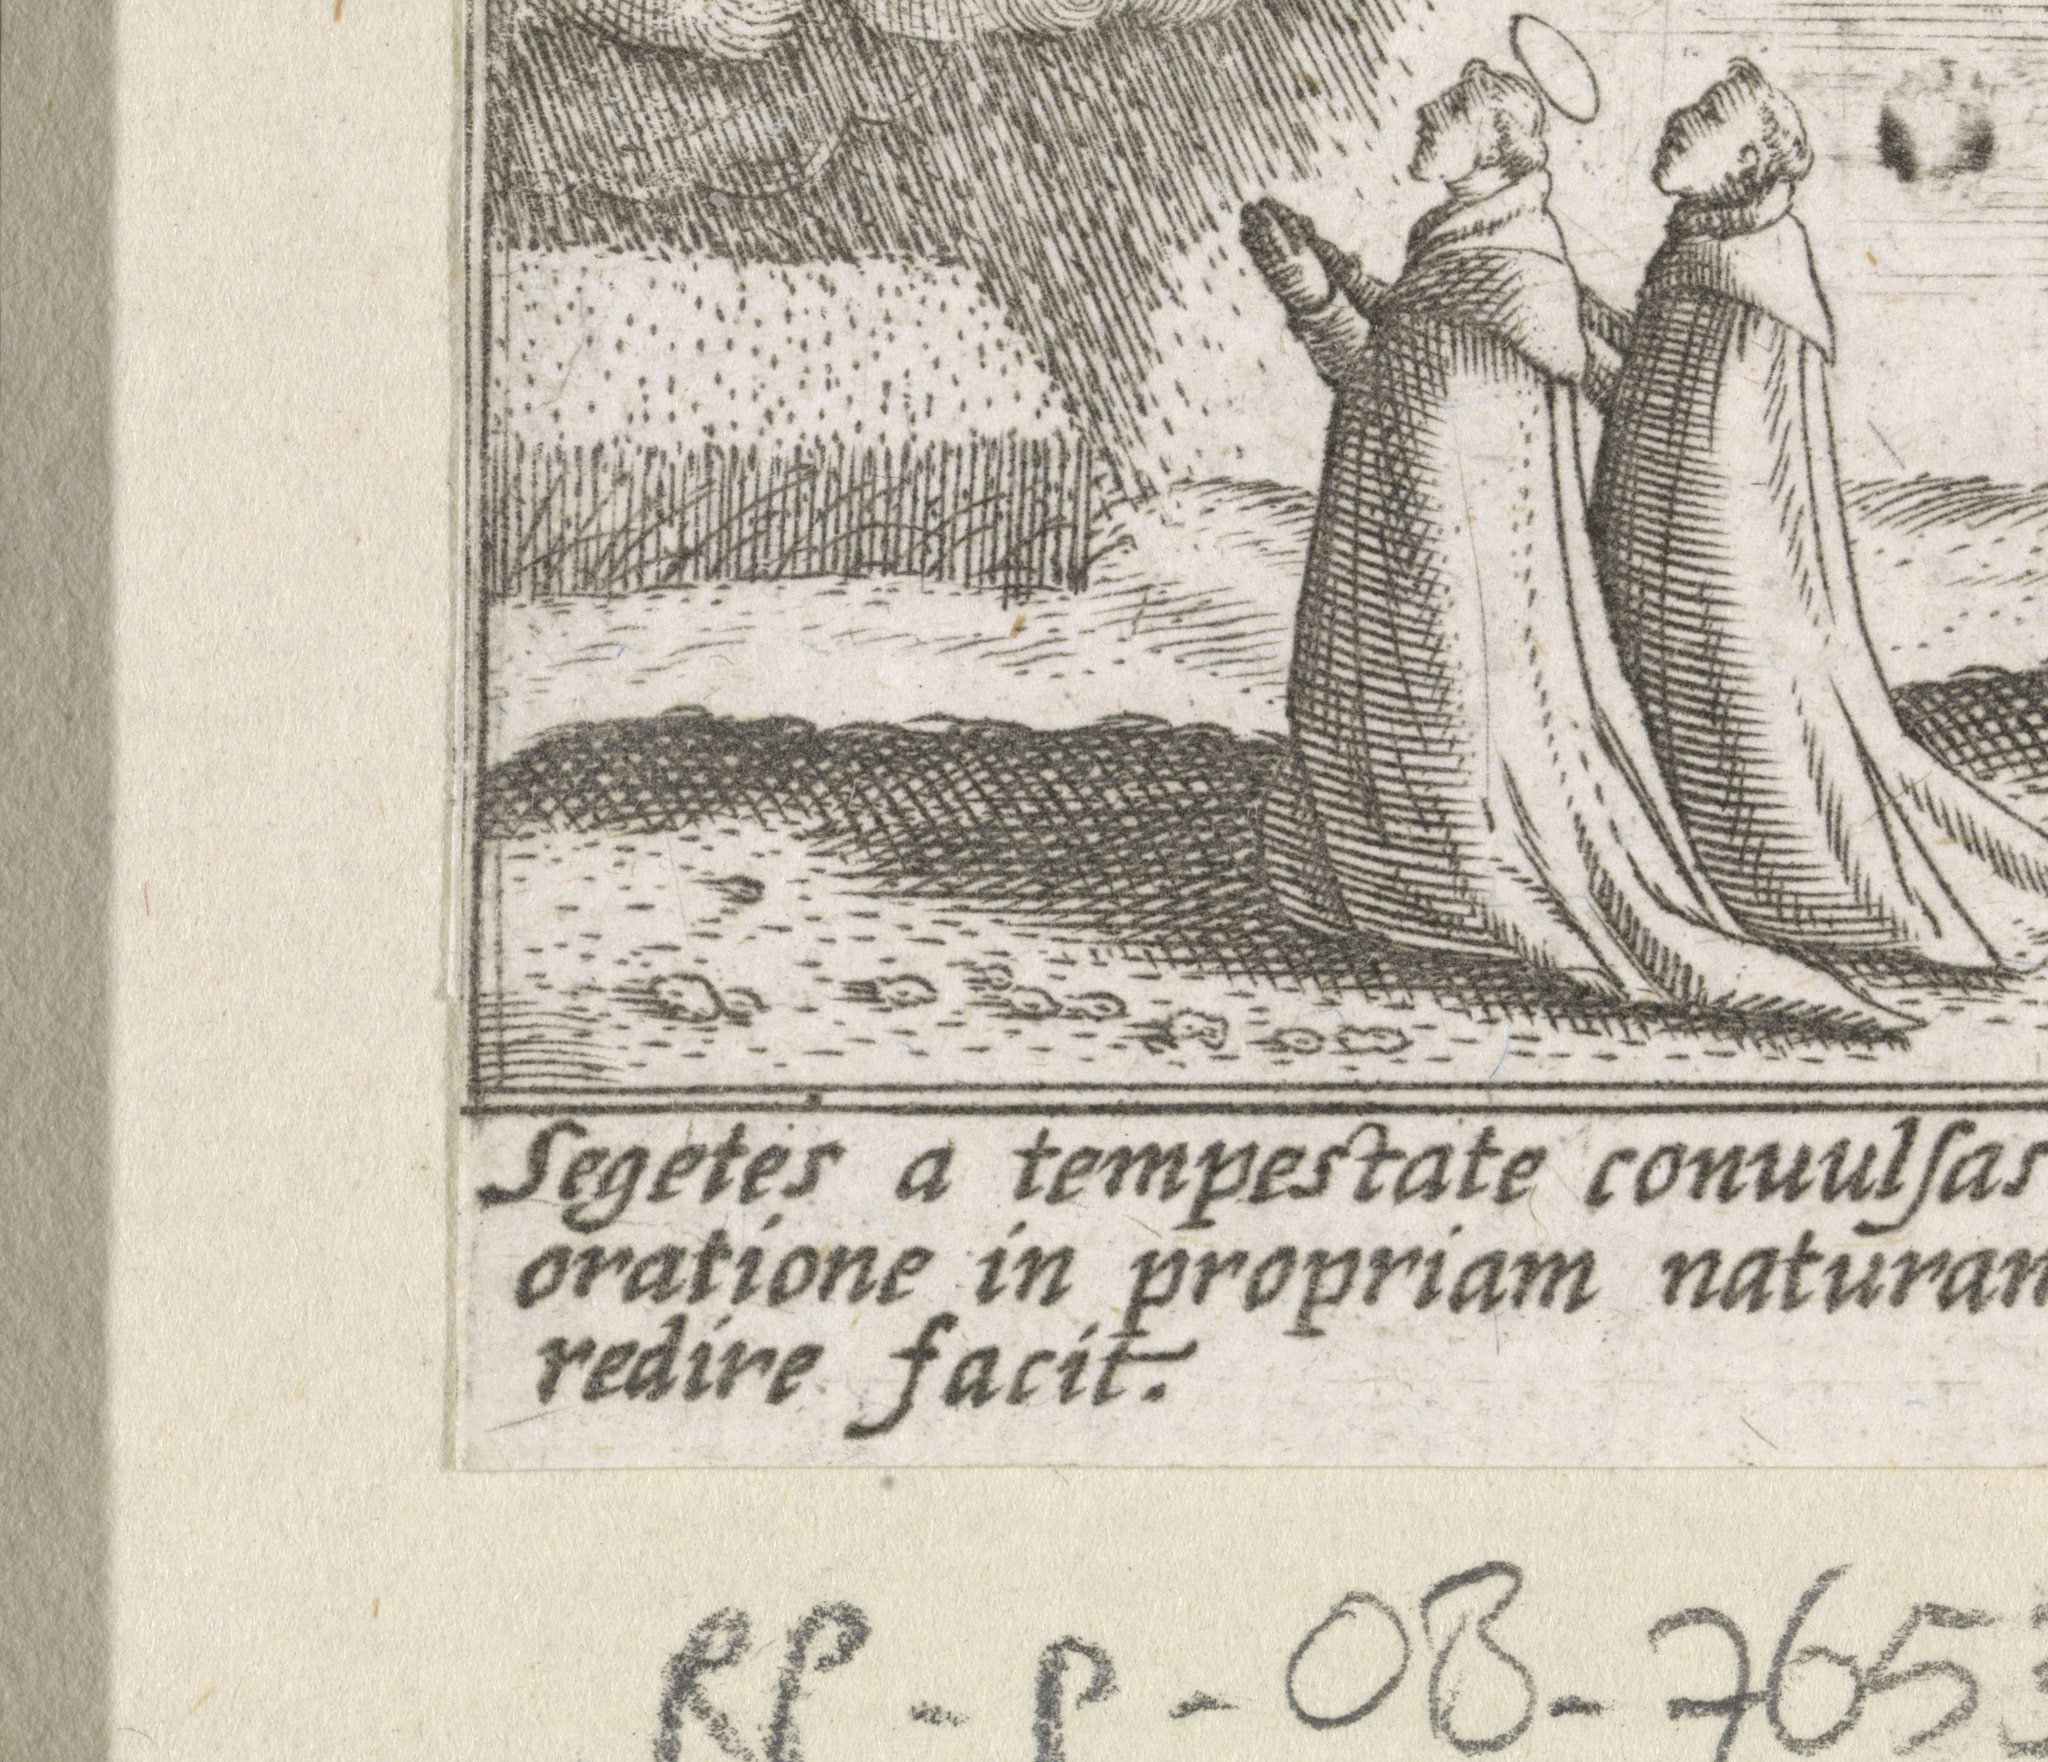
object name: print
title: Mirakels van de Heilige Hyacinthus van Polen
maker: johann sadeler (i)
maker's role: print maker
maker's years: 1550-1600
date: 1595-1600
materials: paper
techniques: engraving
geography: venice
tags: miraculous activities and events ~ st. hyacinth, monk(s), friar(s), storm on land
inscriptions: collector's mark: Lugt 240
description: De H. Hyacinthus van Polen en een monnik bidden geknield voor een korenveld dat door een storm wordt geteisterd. Hun gebed beëindigt de storm. De prent maakt deel uit van een achttiendelige serie die een kader vormt rondom een afbeelding van de H. Hyacinthus van Polen.